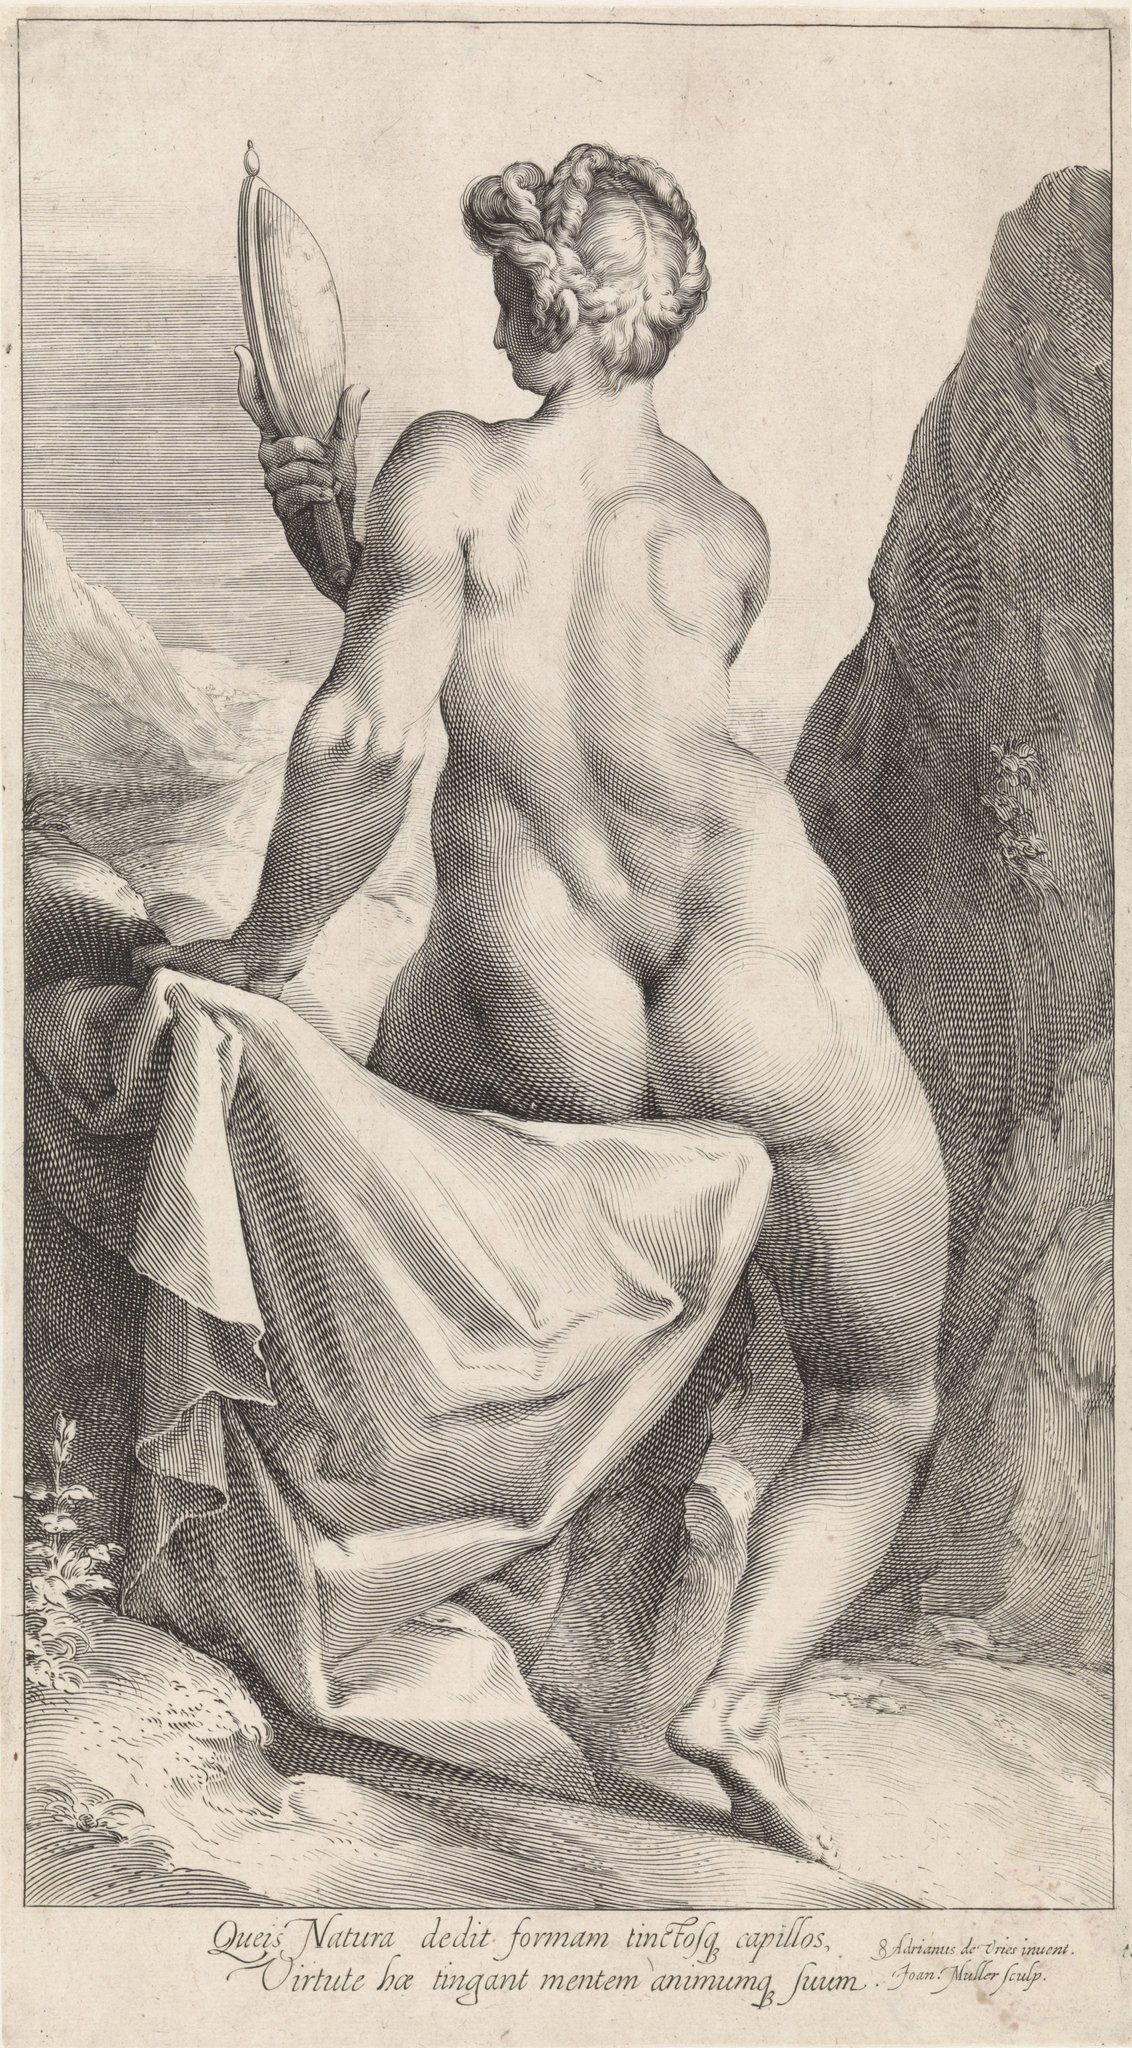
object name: print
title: Voorzichtigheid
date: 1595-1599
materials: paper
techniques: engraving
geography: amsterdam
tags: prudence, 'prudentia'; 'prudenza' (ripa) ~ one of the four cardinal virtues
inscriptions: collector's mark: Lugt 240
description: Prudentia (voorzichtigheid) als naakte vrouw, zittend, op de rug gezien, kijkend in een spiegel.